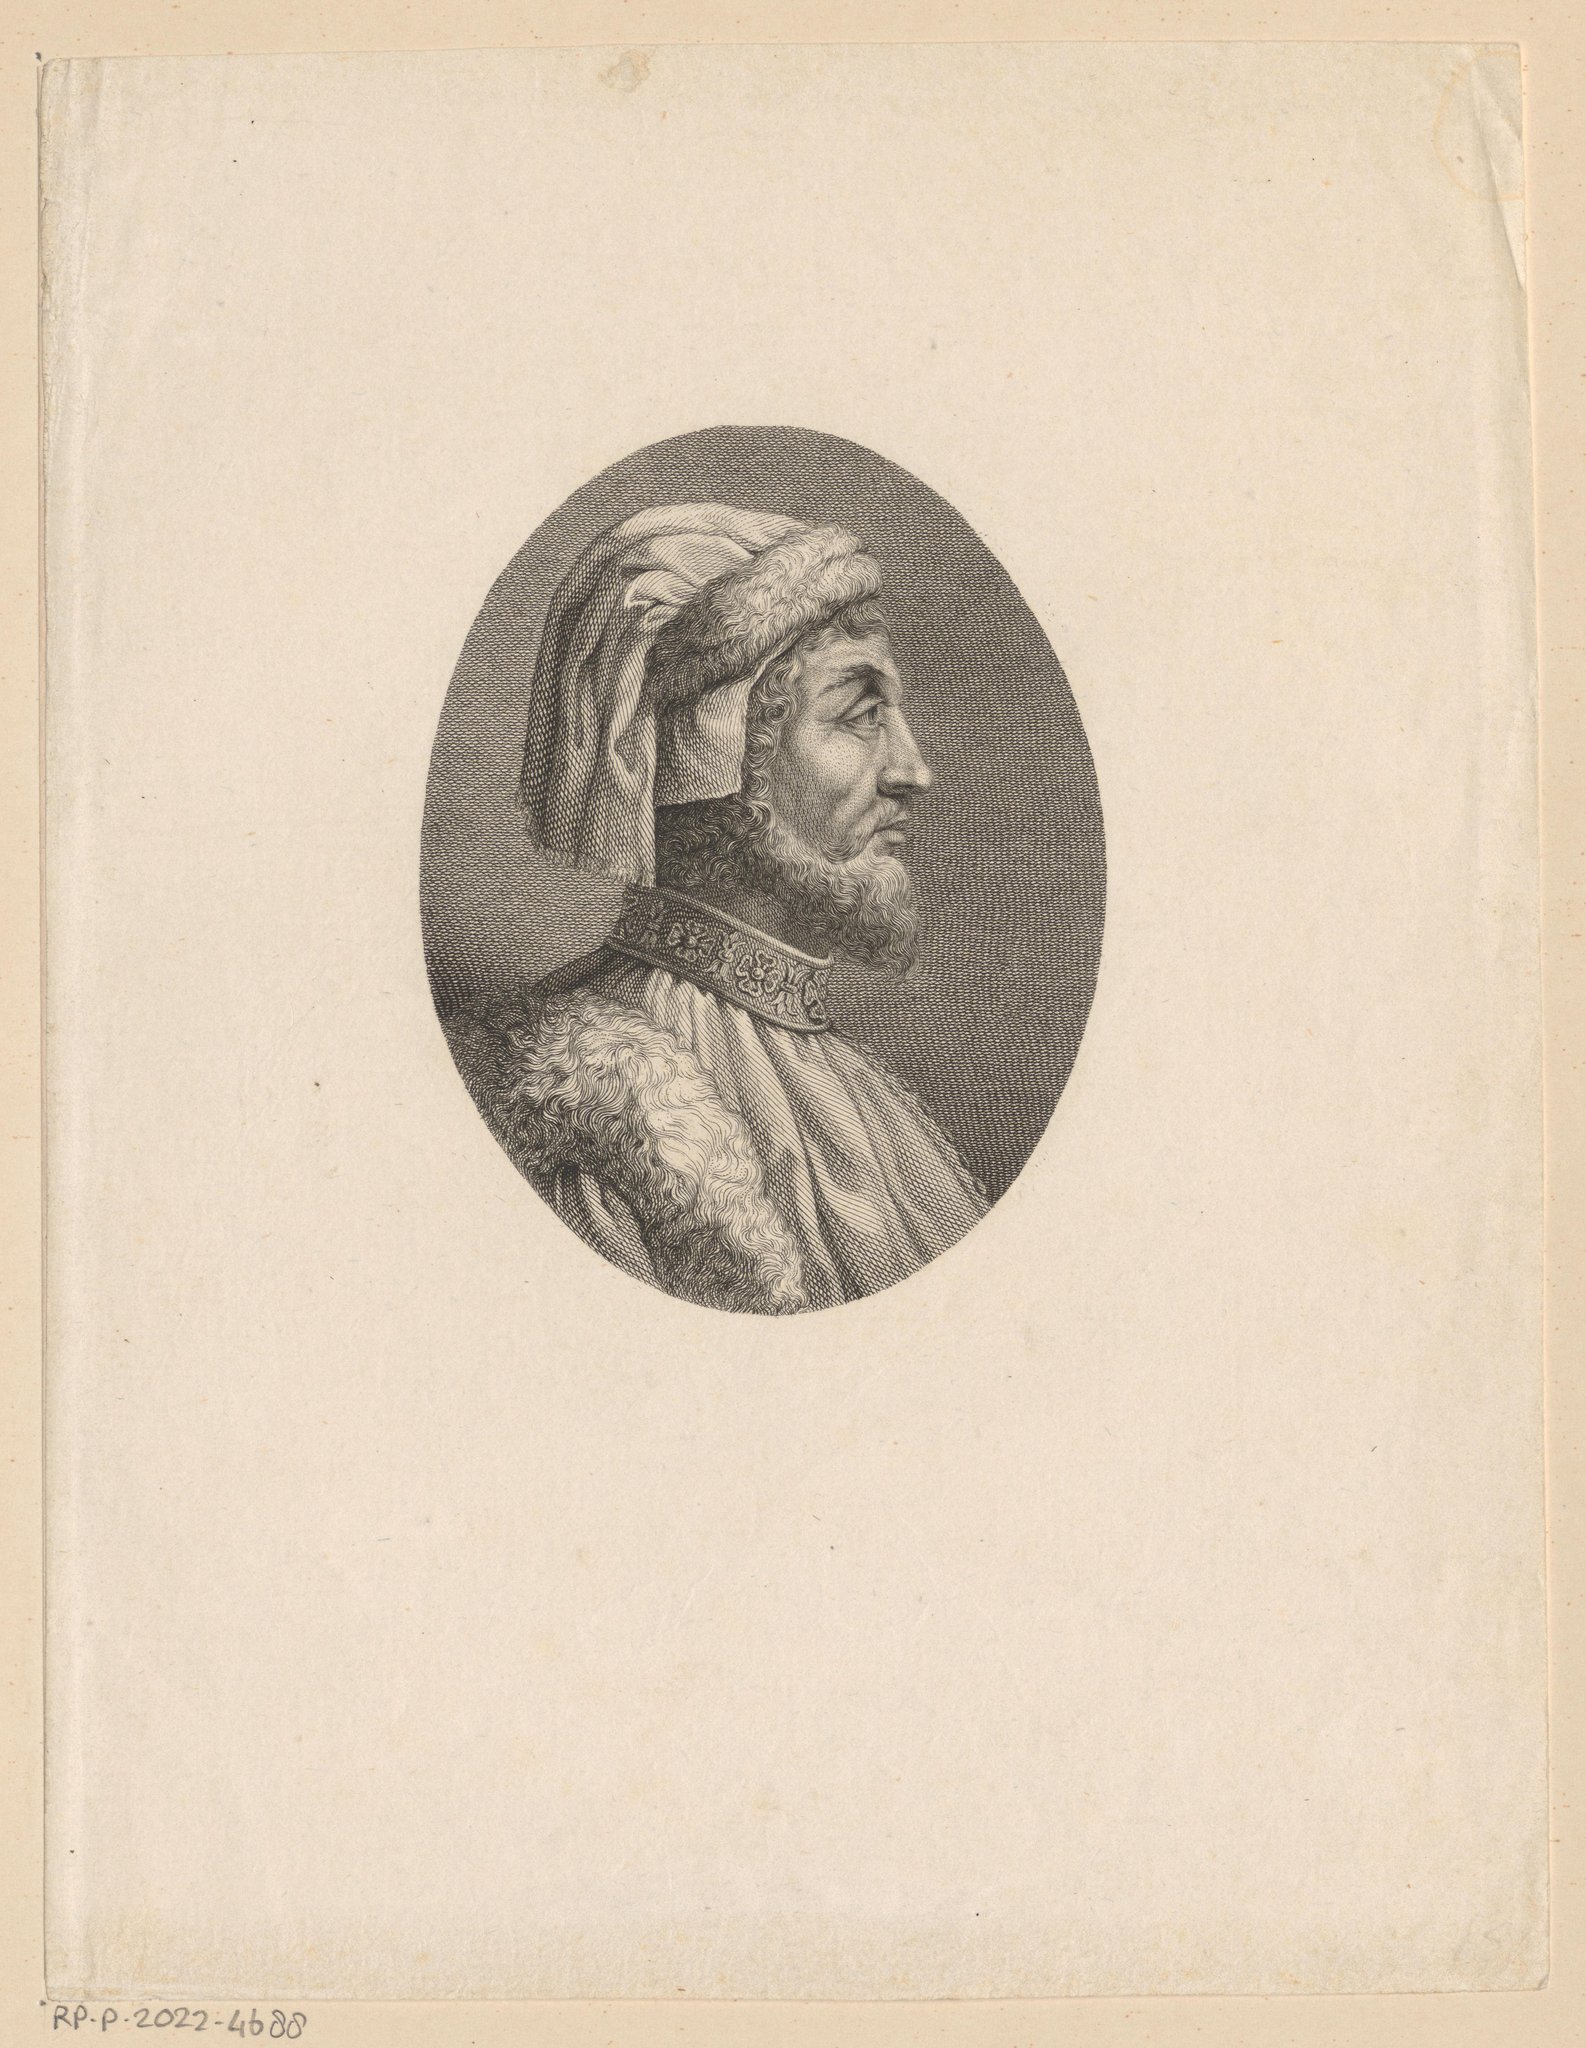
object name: print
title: Portret van Azzone Visconti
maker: Anonymous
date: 1775-1850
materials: paper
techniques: etching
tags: politician, historical persons, ruler, sovereign